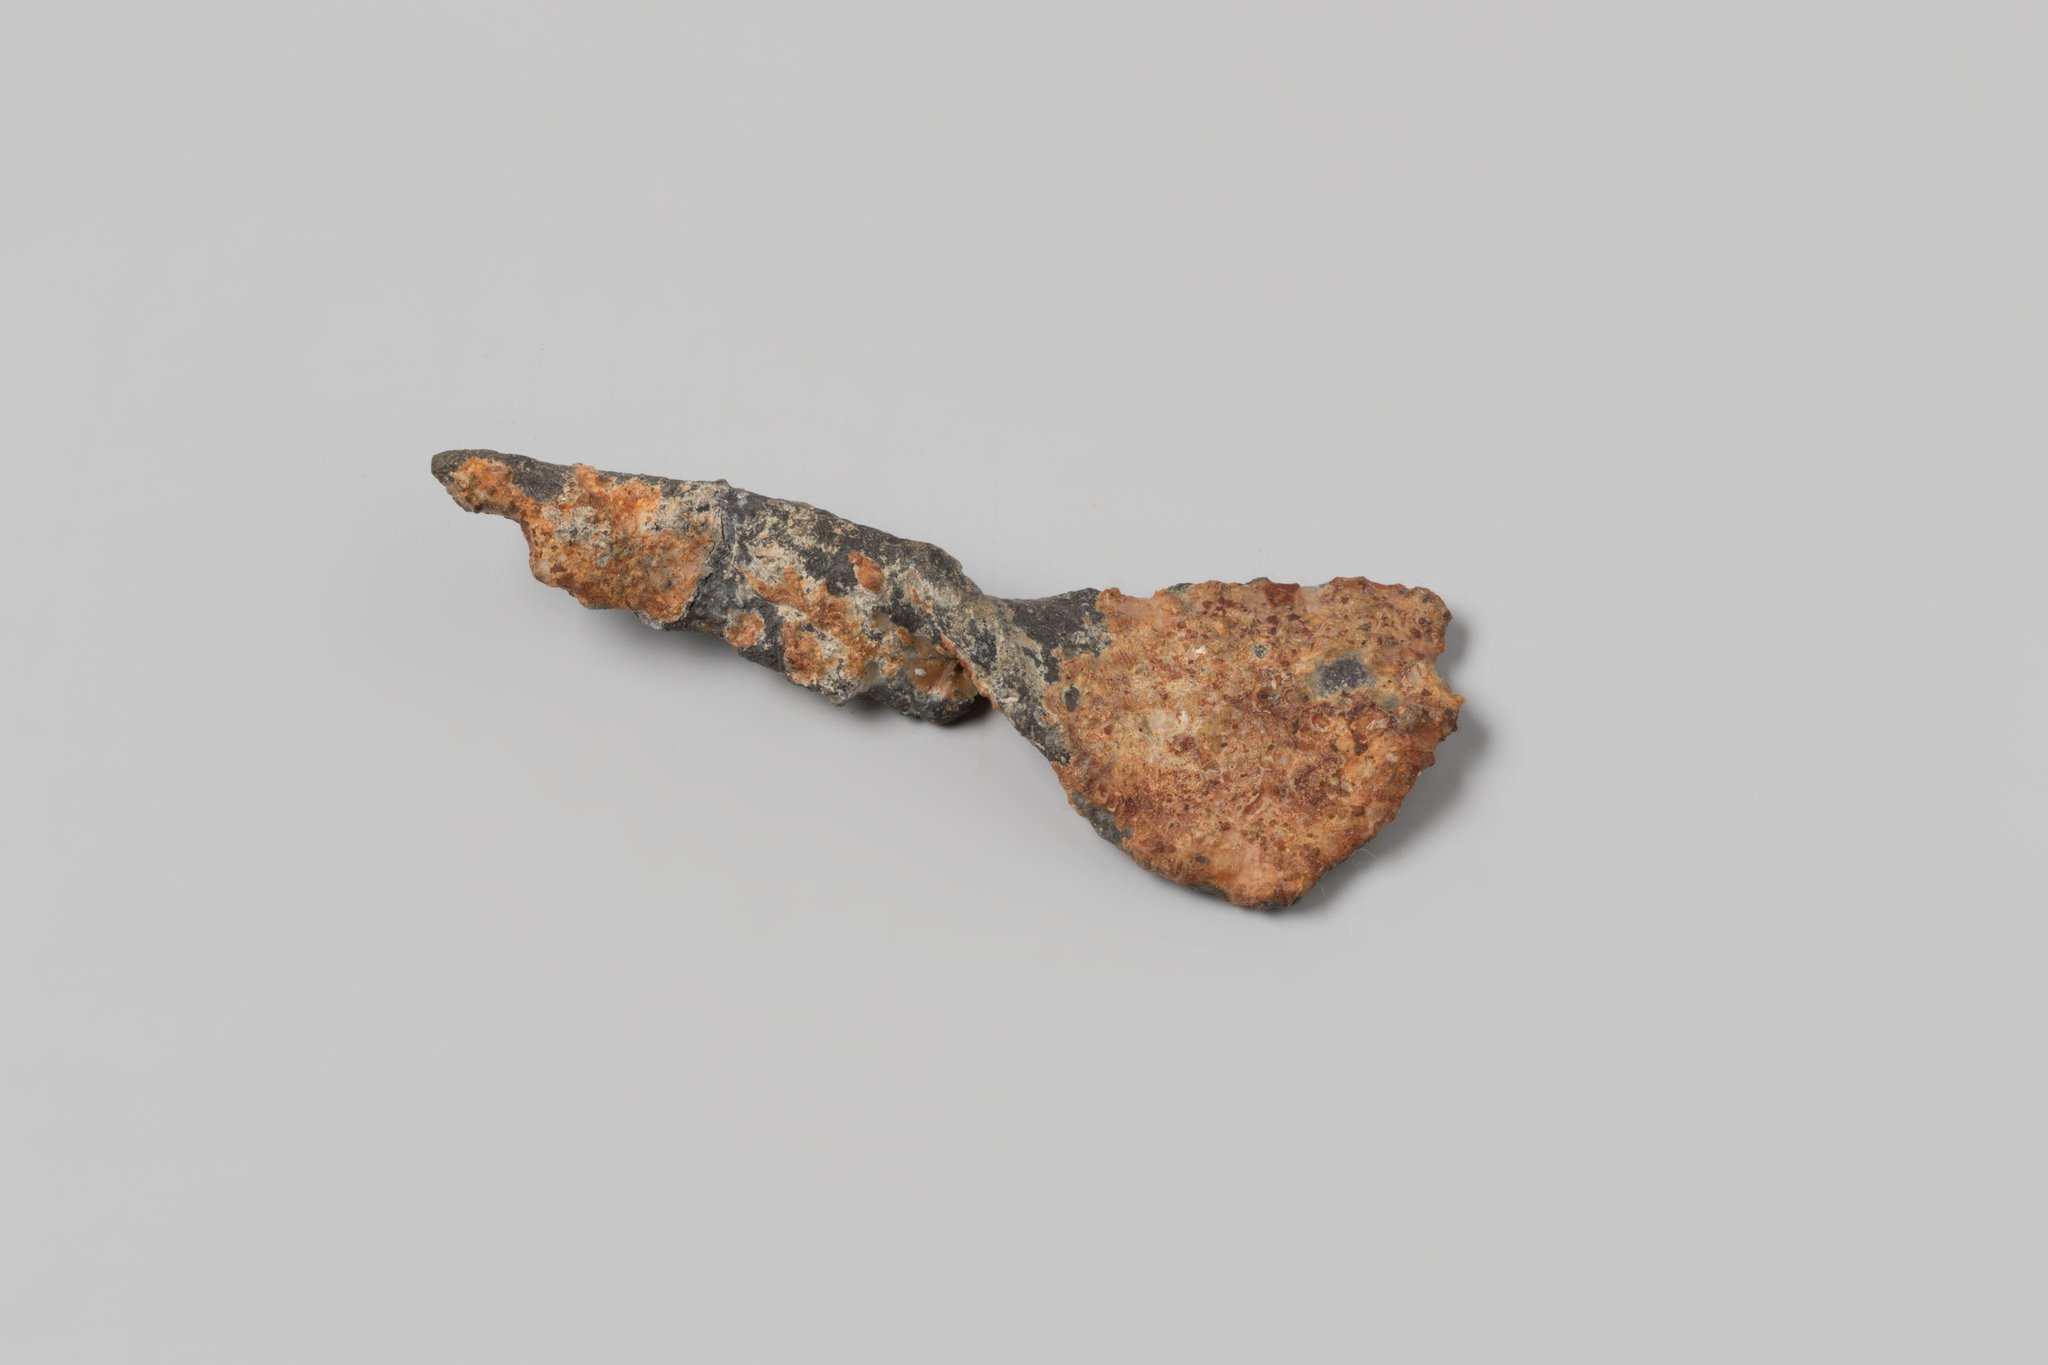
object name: fragment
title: Fragment lood uit het wrak van de Oost-Indiëvaarder Hollandia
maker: Anonymous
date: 1700-1743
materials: lead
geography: netherlands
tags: verenigde oostindische compagnie, hollandia (schip), annet